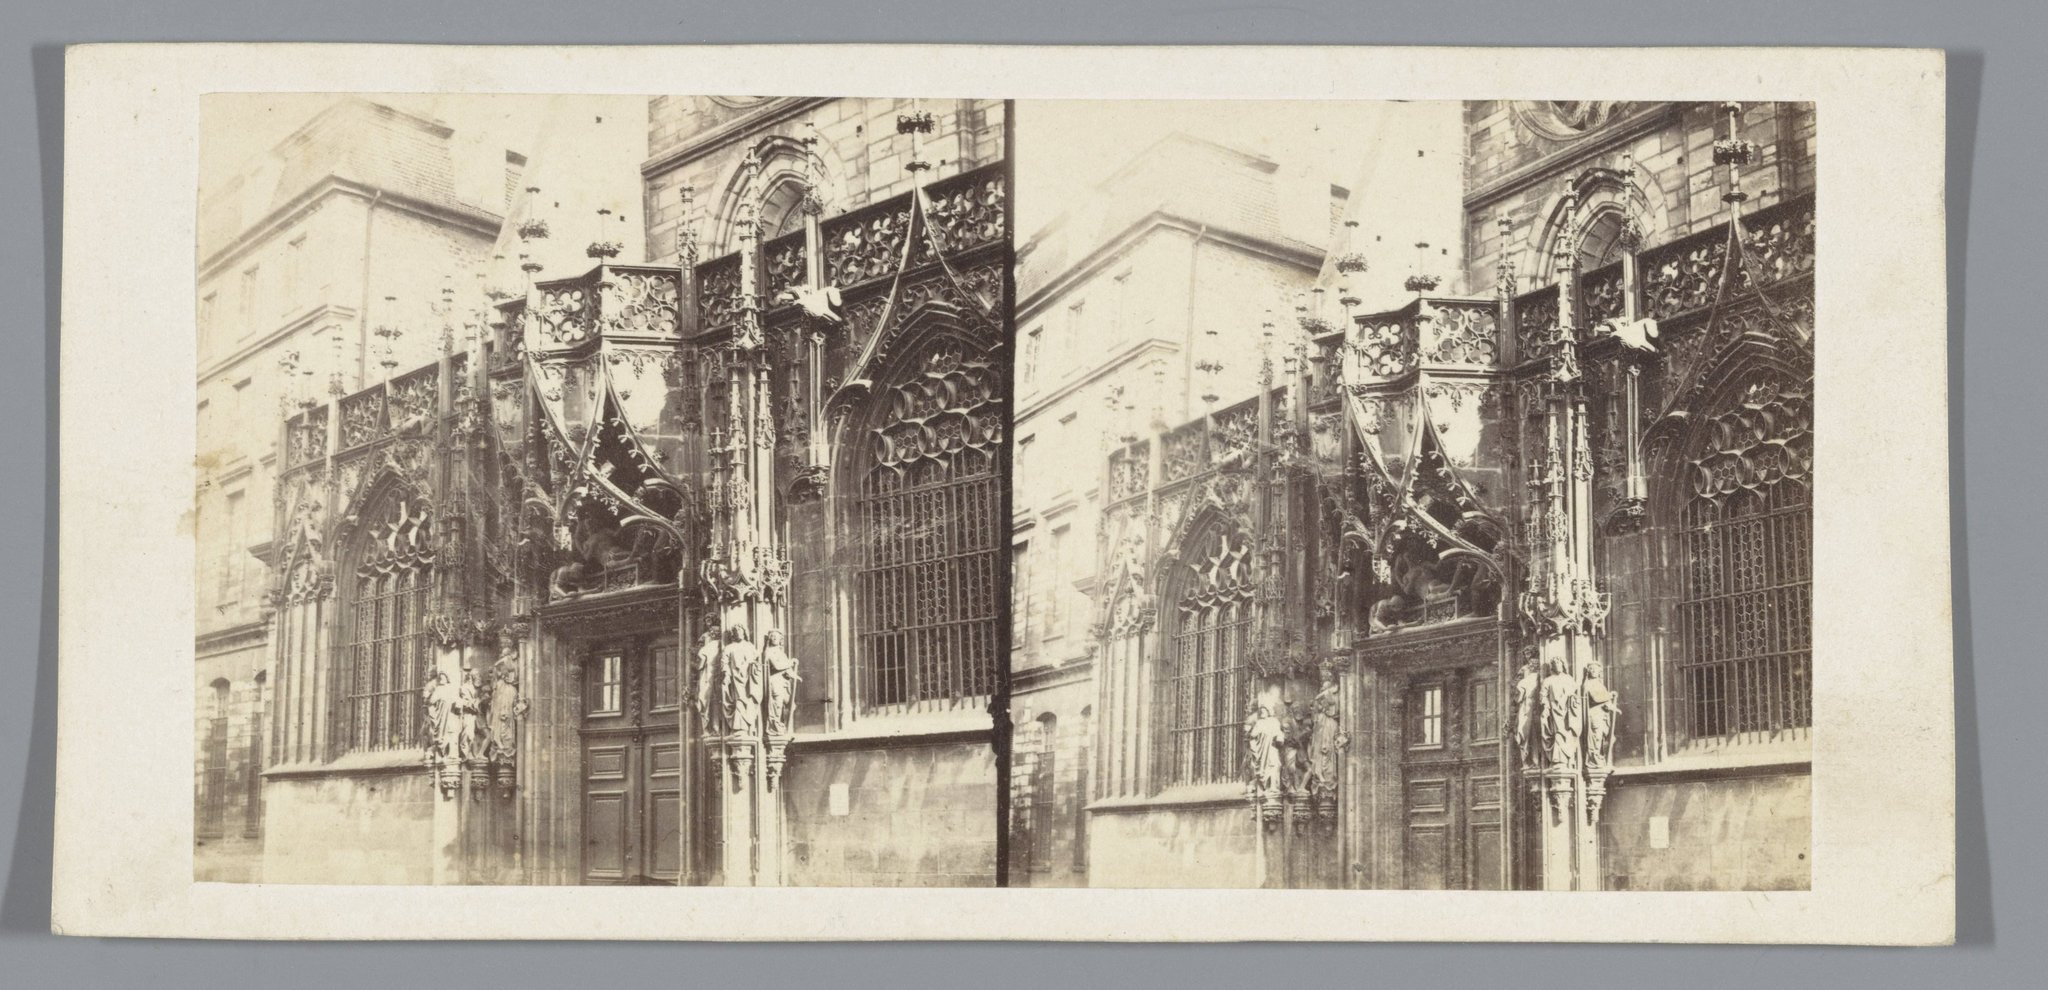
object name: stereograph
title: Gezicht op een portaal van de Notre-Dame van Straatsburg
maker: Anonymous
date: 1850-1880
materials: cardboard, photographic support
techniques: albumen print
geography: straatsburg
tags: parts of church exterior and annexes: portal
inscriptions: inscription: ‘Portail St Laurent, Cathédrale de Strasbourg’